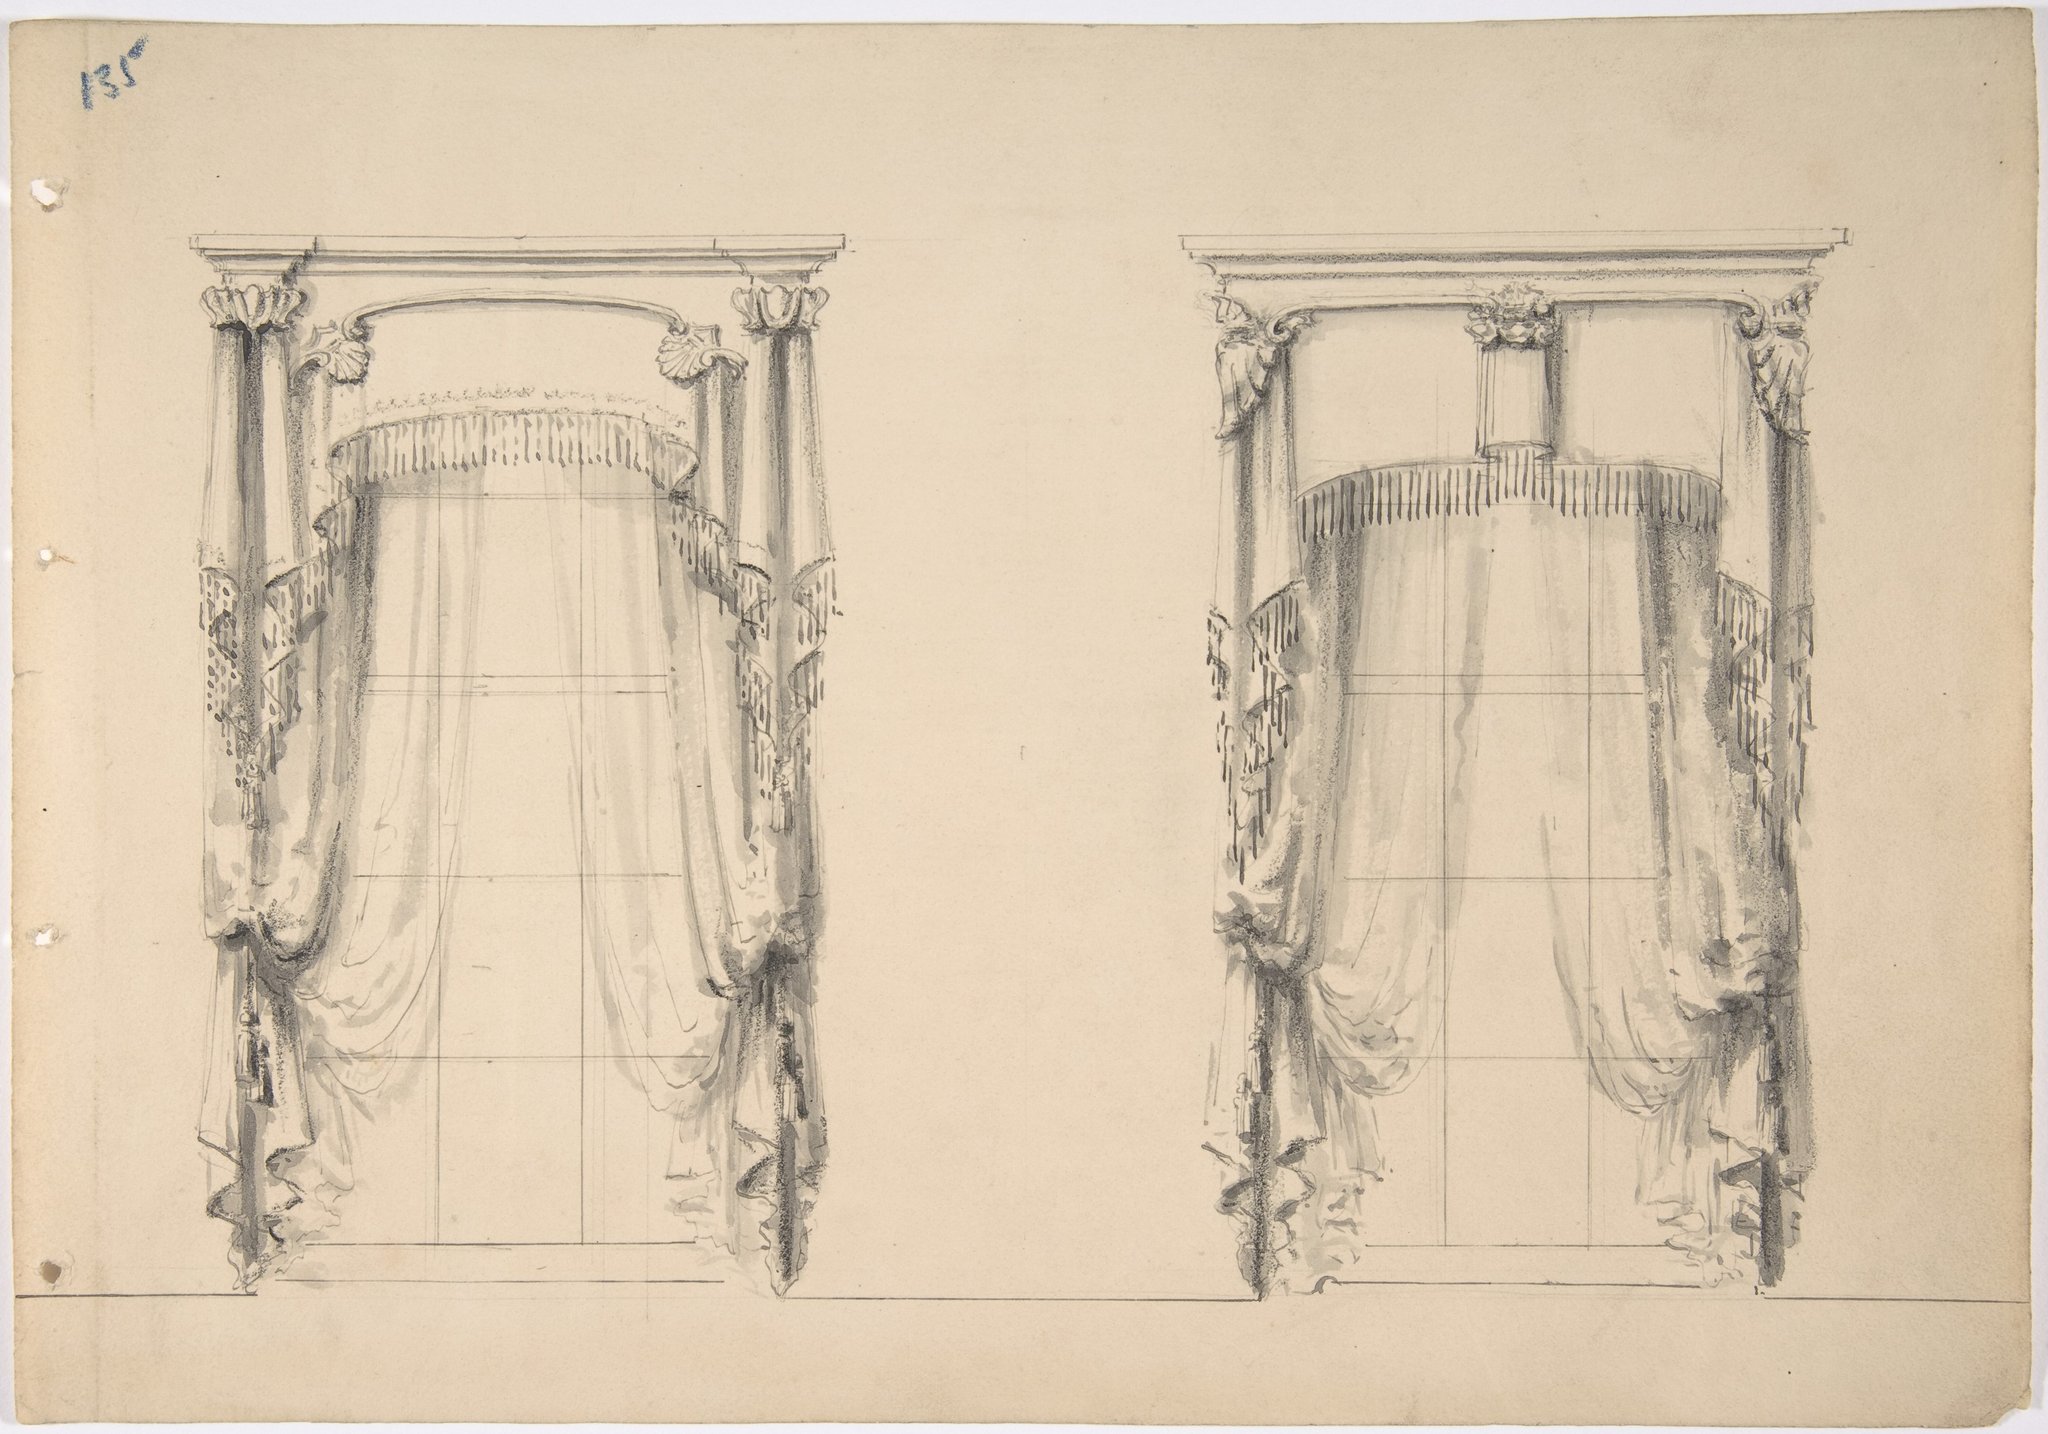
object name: drawing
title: Design for Fringed Curtains Hanging at Two Windows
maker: anonymous, british, 19th century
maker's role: artist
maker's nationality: british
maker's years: 1800-1900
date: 1801-1833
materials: ink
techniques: brush, pen, wash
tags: windows,curtains